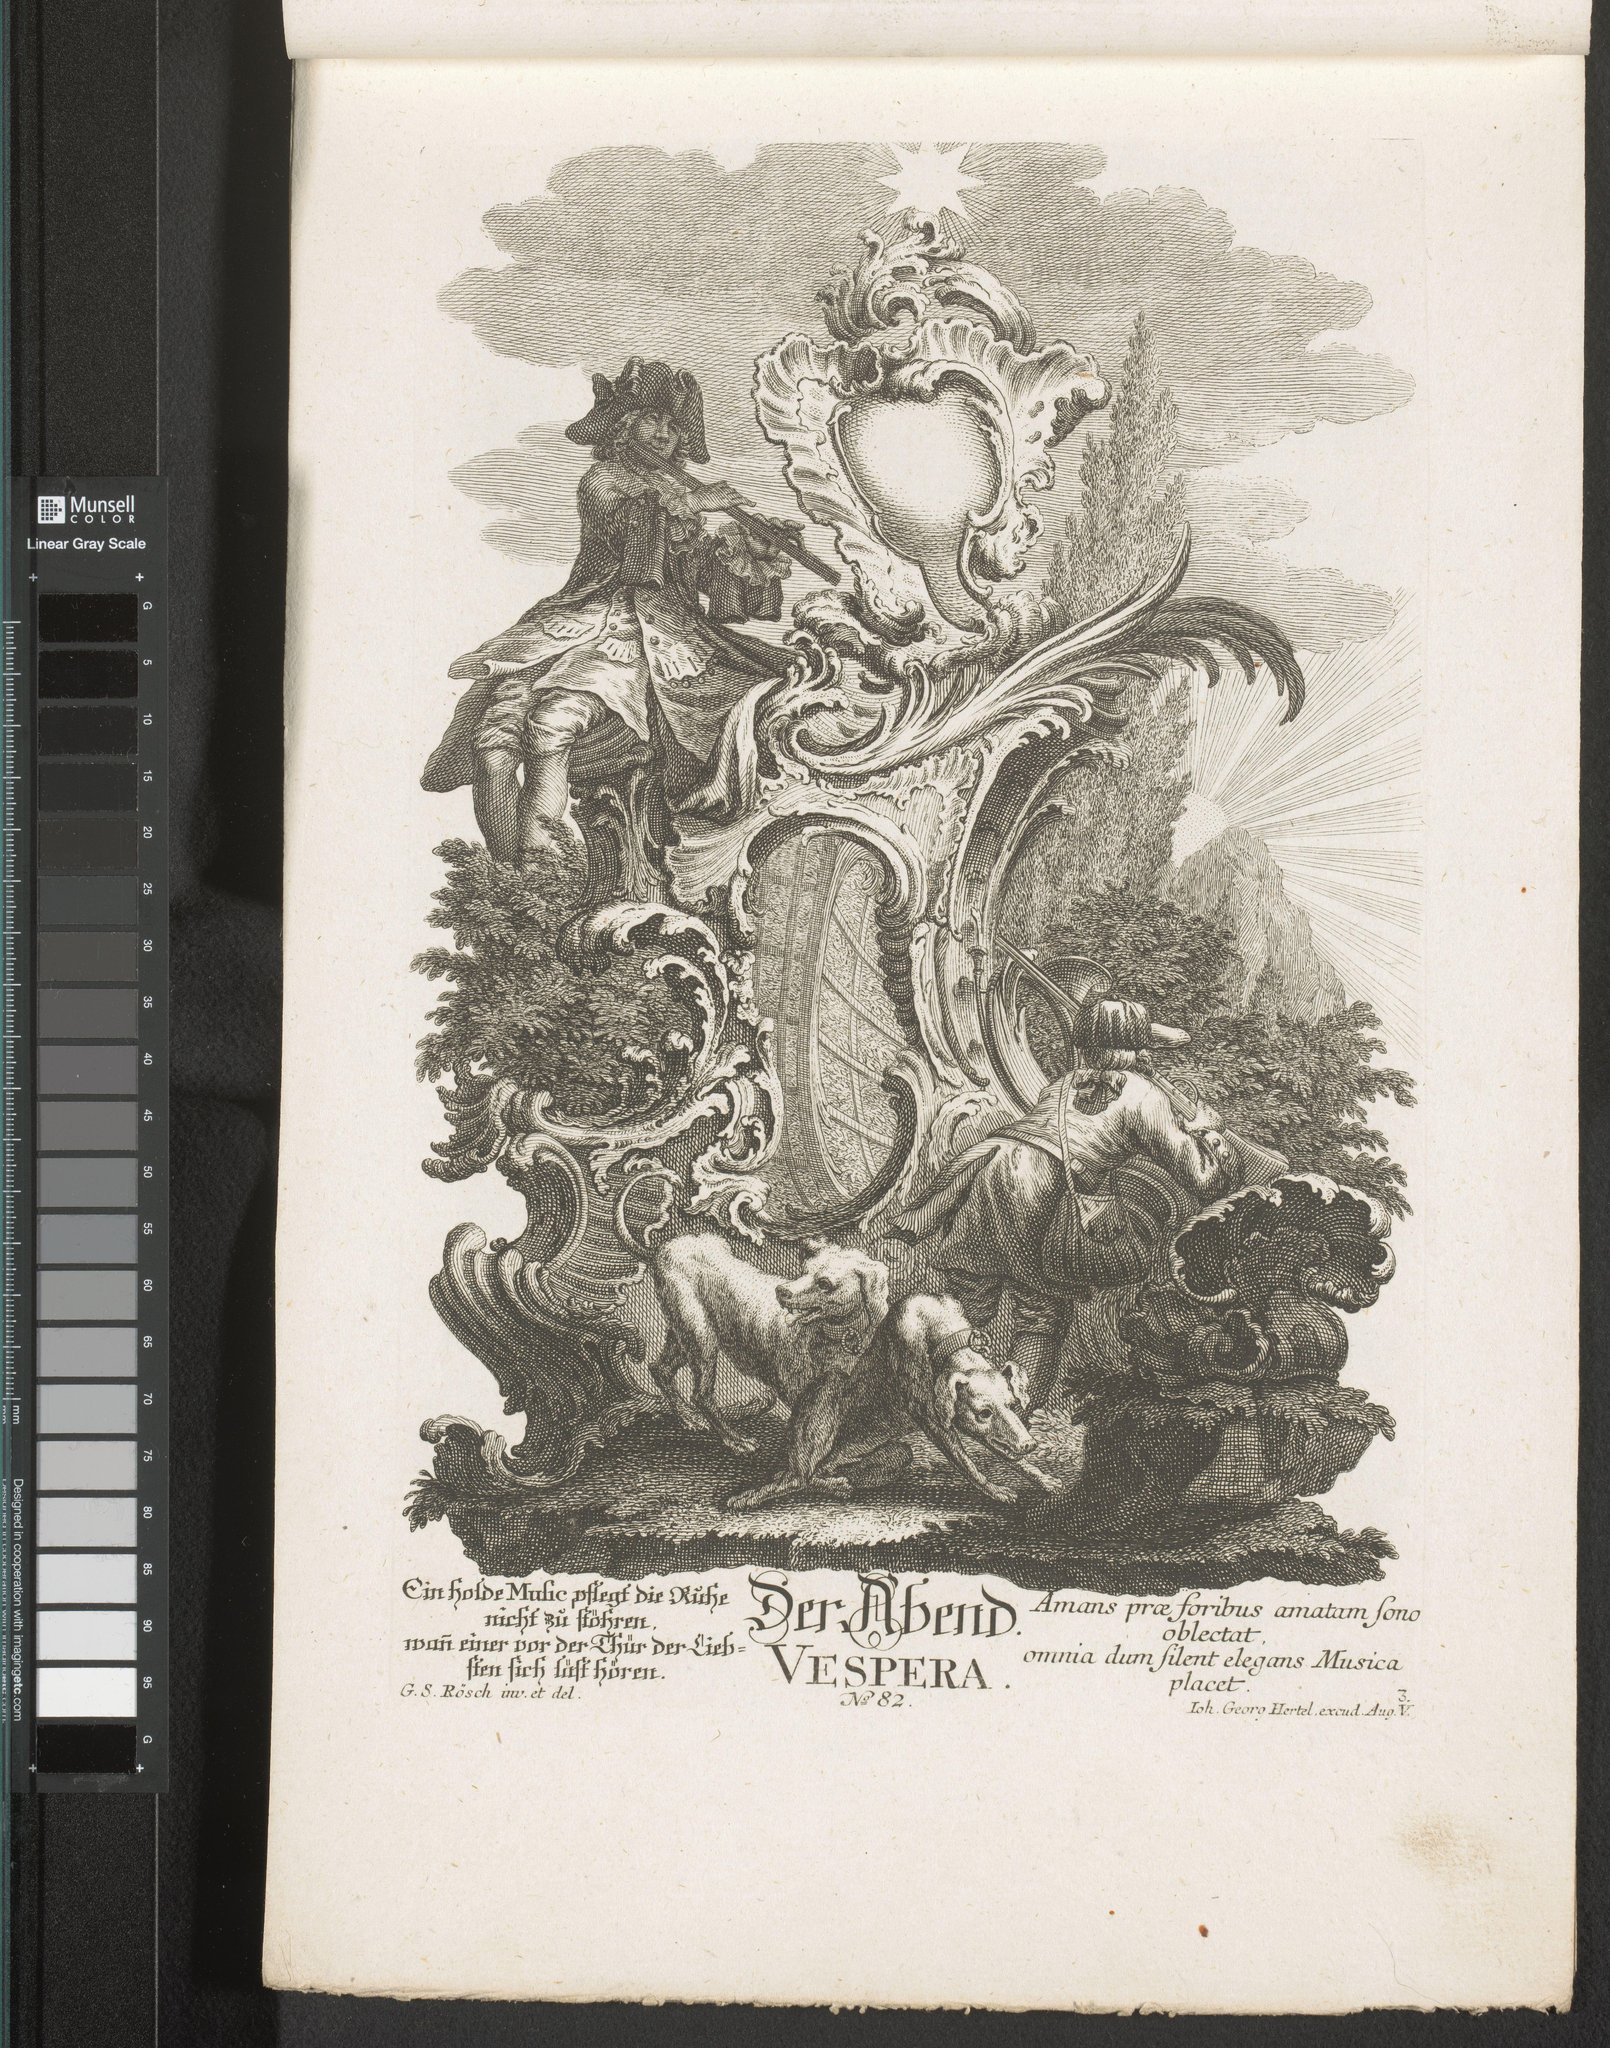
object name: print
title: Mors en Pluto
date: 1731-1775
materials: paper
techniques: engraving, etching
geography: augsburg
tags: specific aspects, allegorical aspects of pluto; pluto as patron, thanatos (mors), death (+ specific aspects, allegorical aspects), ornament ~ cartouche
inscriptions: collector's mark: Lugt 2228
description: Twee cartouches met busten van goden. Links Mors als skelet met uitgeblazen kaars, zandloper, boek, schep en zeis. Rechts Pluto met kroon en scepter. Onder de cartouche een voorstelling van de overtocht van de veerman Charon over de rivier de Styx. Uitgeversnummer 56.